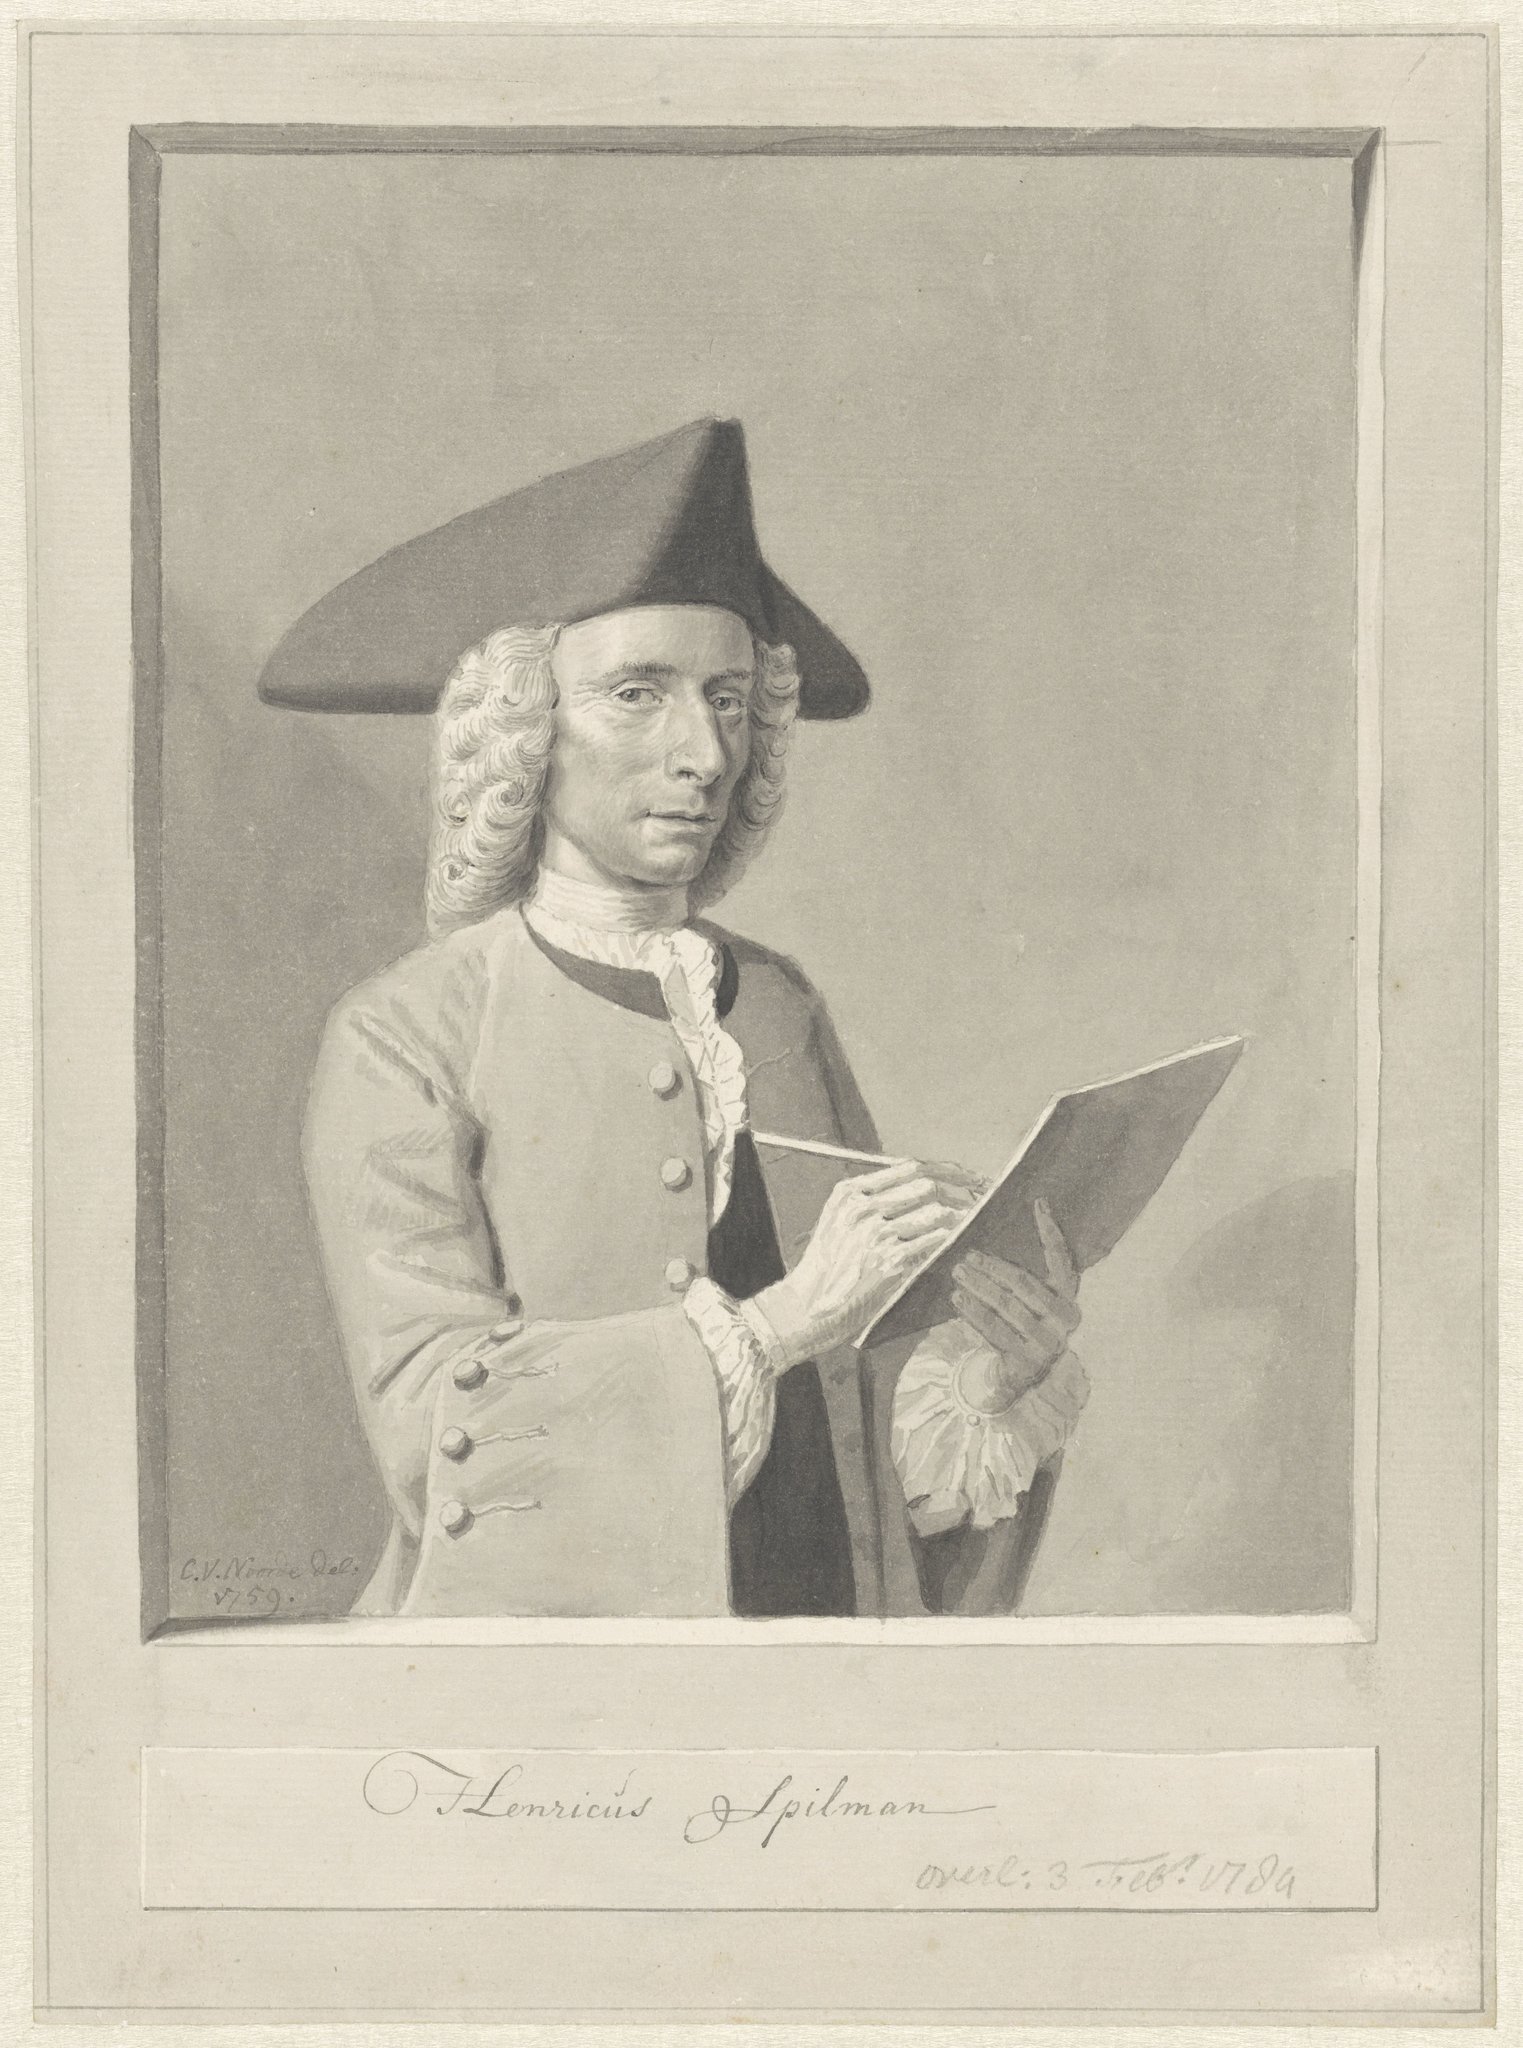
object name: drawing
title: Portret van Hendrik Spilman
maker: cornelis van noorde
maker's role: draughtsman, print maker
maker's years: 1731-1795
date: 1759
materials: ink, paper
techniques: pen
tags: amsterdam, painter, hendrik spilman, historical persons, portrait, self-portrait of artist